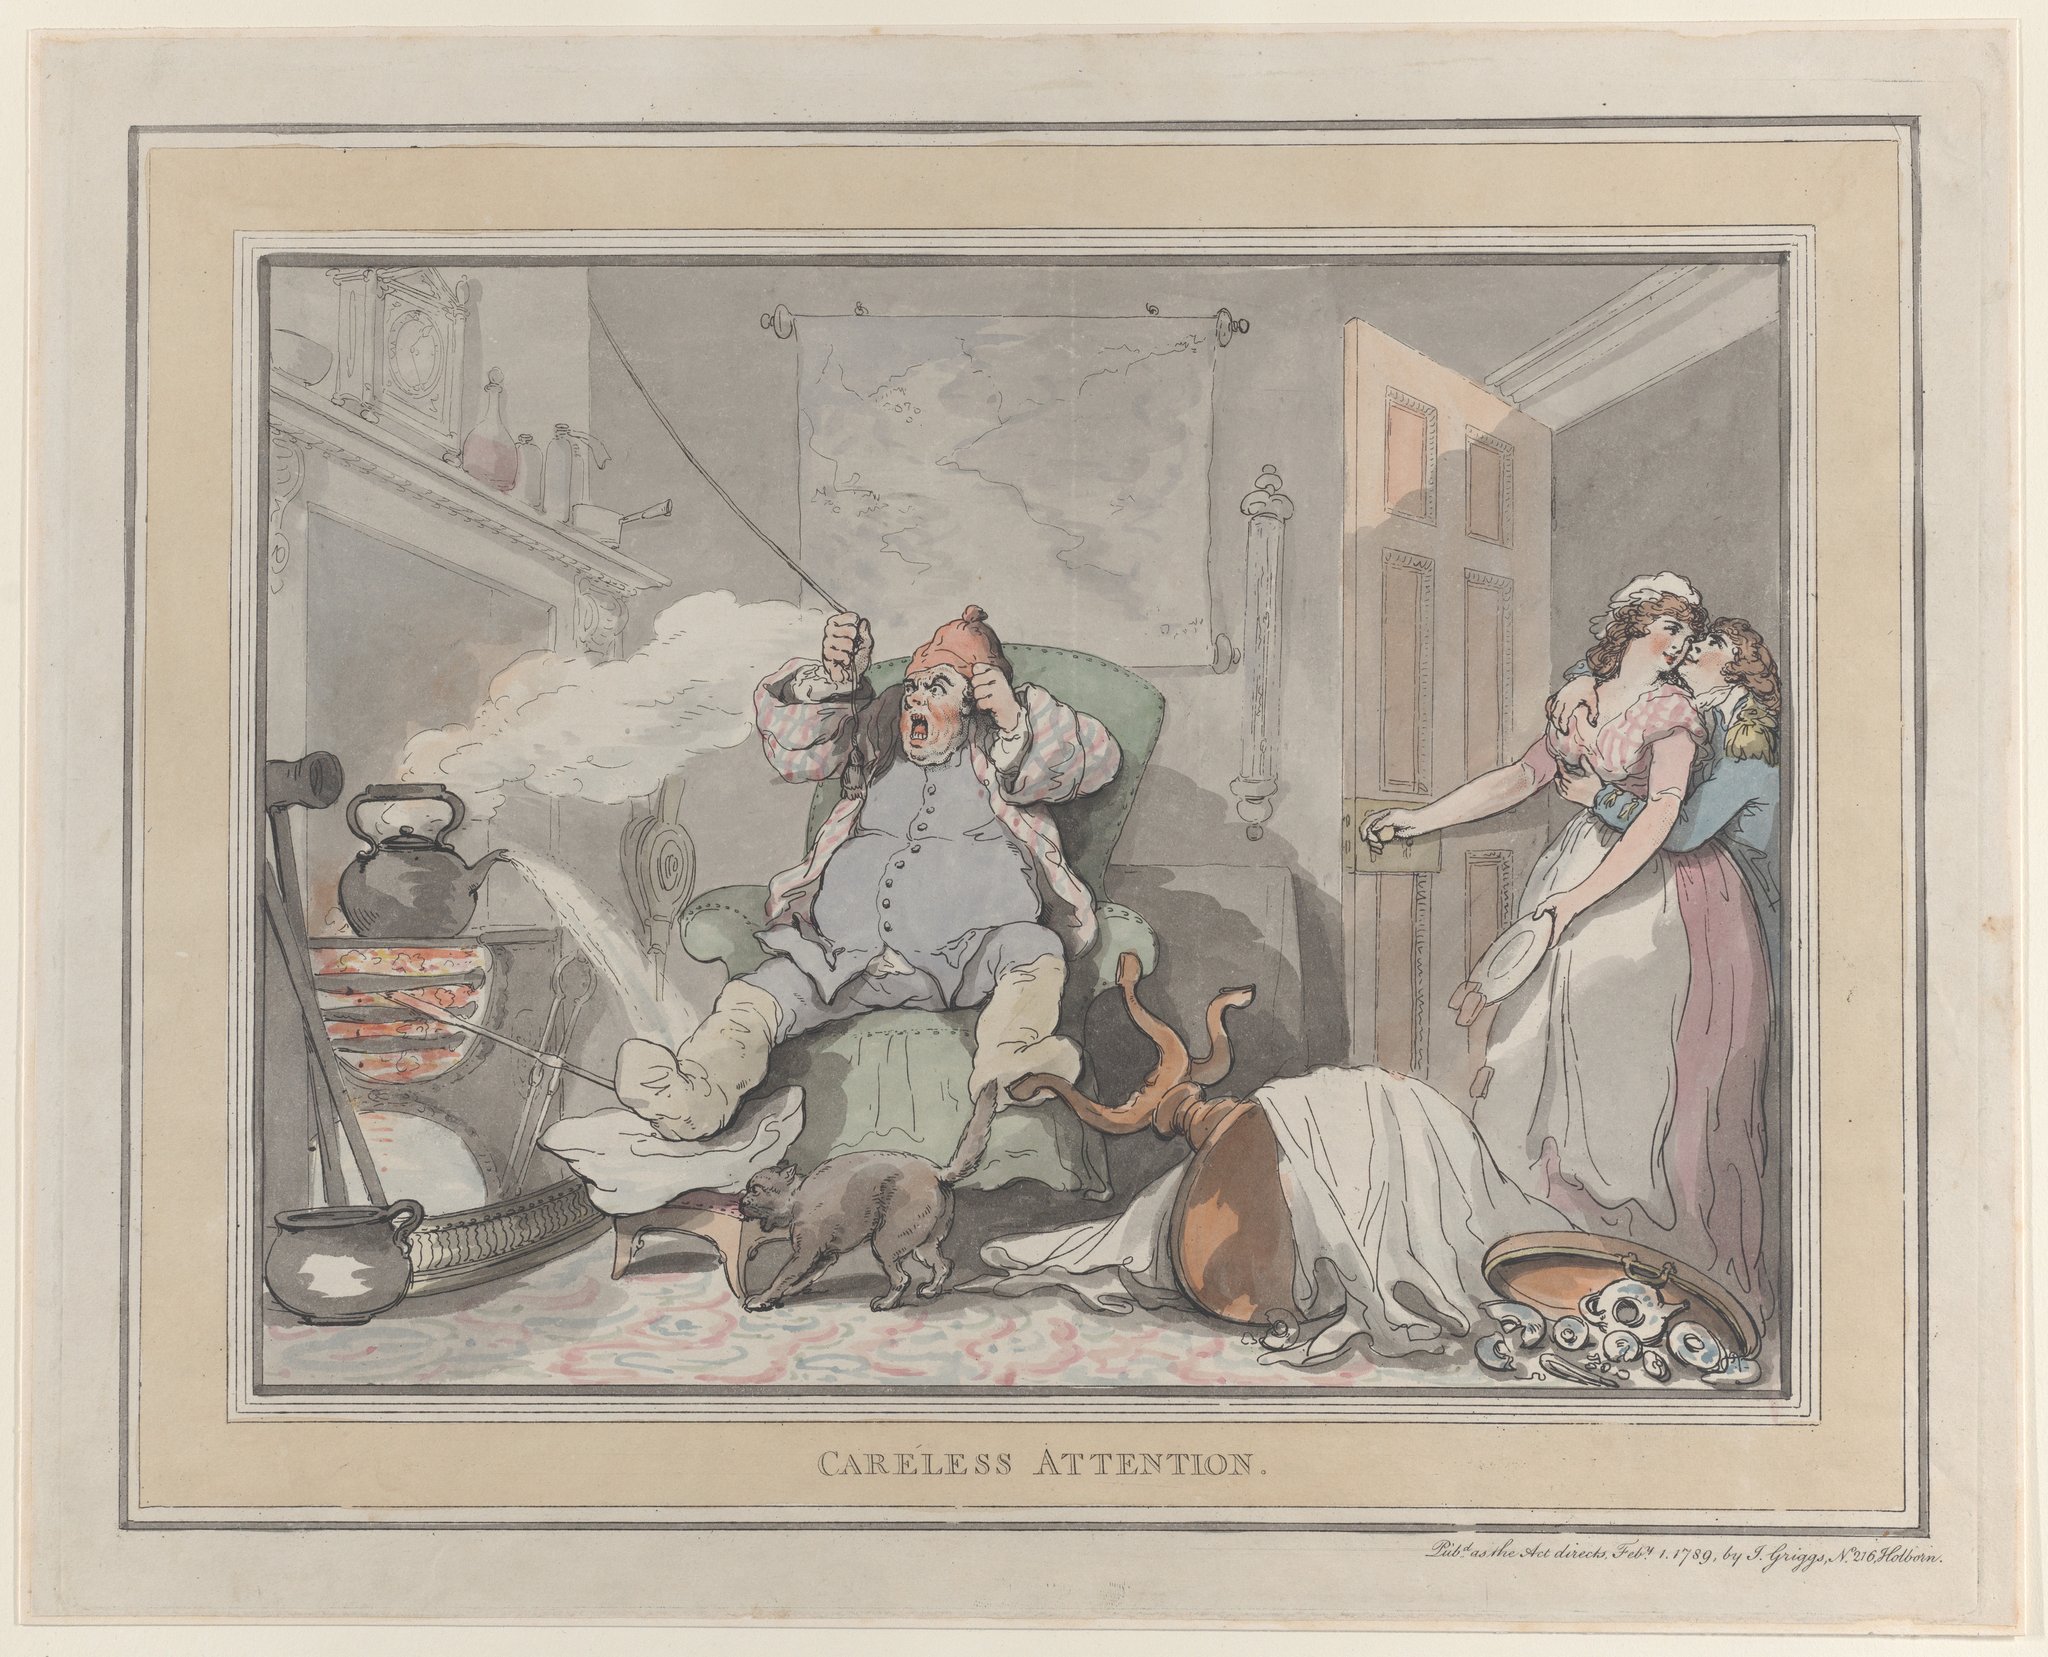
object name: print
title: Careless Attention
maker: thomas rowlandson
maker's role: artist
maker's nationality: british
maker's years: 1757-1827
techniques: etching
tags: satire,couples,men,women,cats